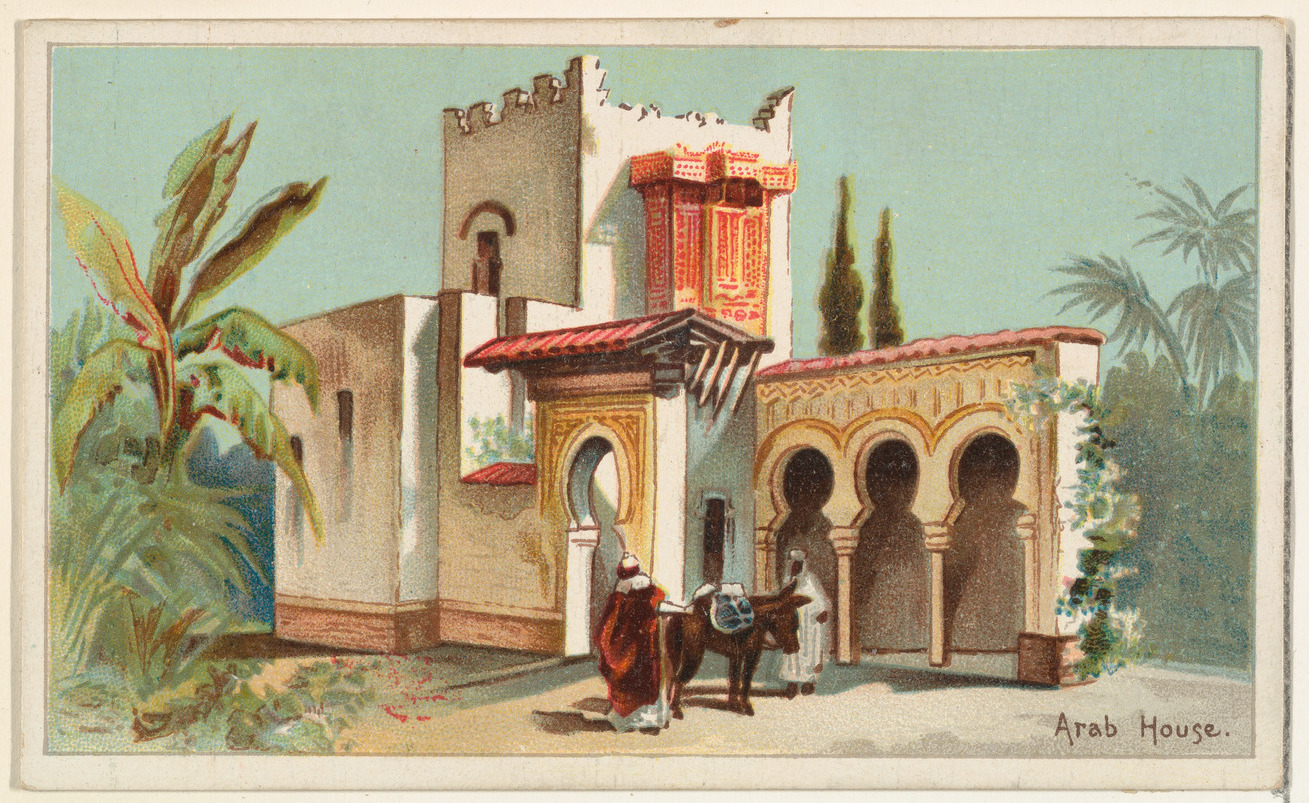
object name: print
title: Arab House, from the Habitations of Man series (N113) issued by W. Duke, Sons & Co. to promote Honest Long Cut Smoking and Chewing Tobacco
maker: the giles company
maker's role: artist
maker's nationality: american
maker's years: 1800-1900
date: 1890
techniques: color lithograph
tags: houses,men,donkeys